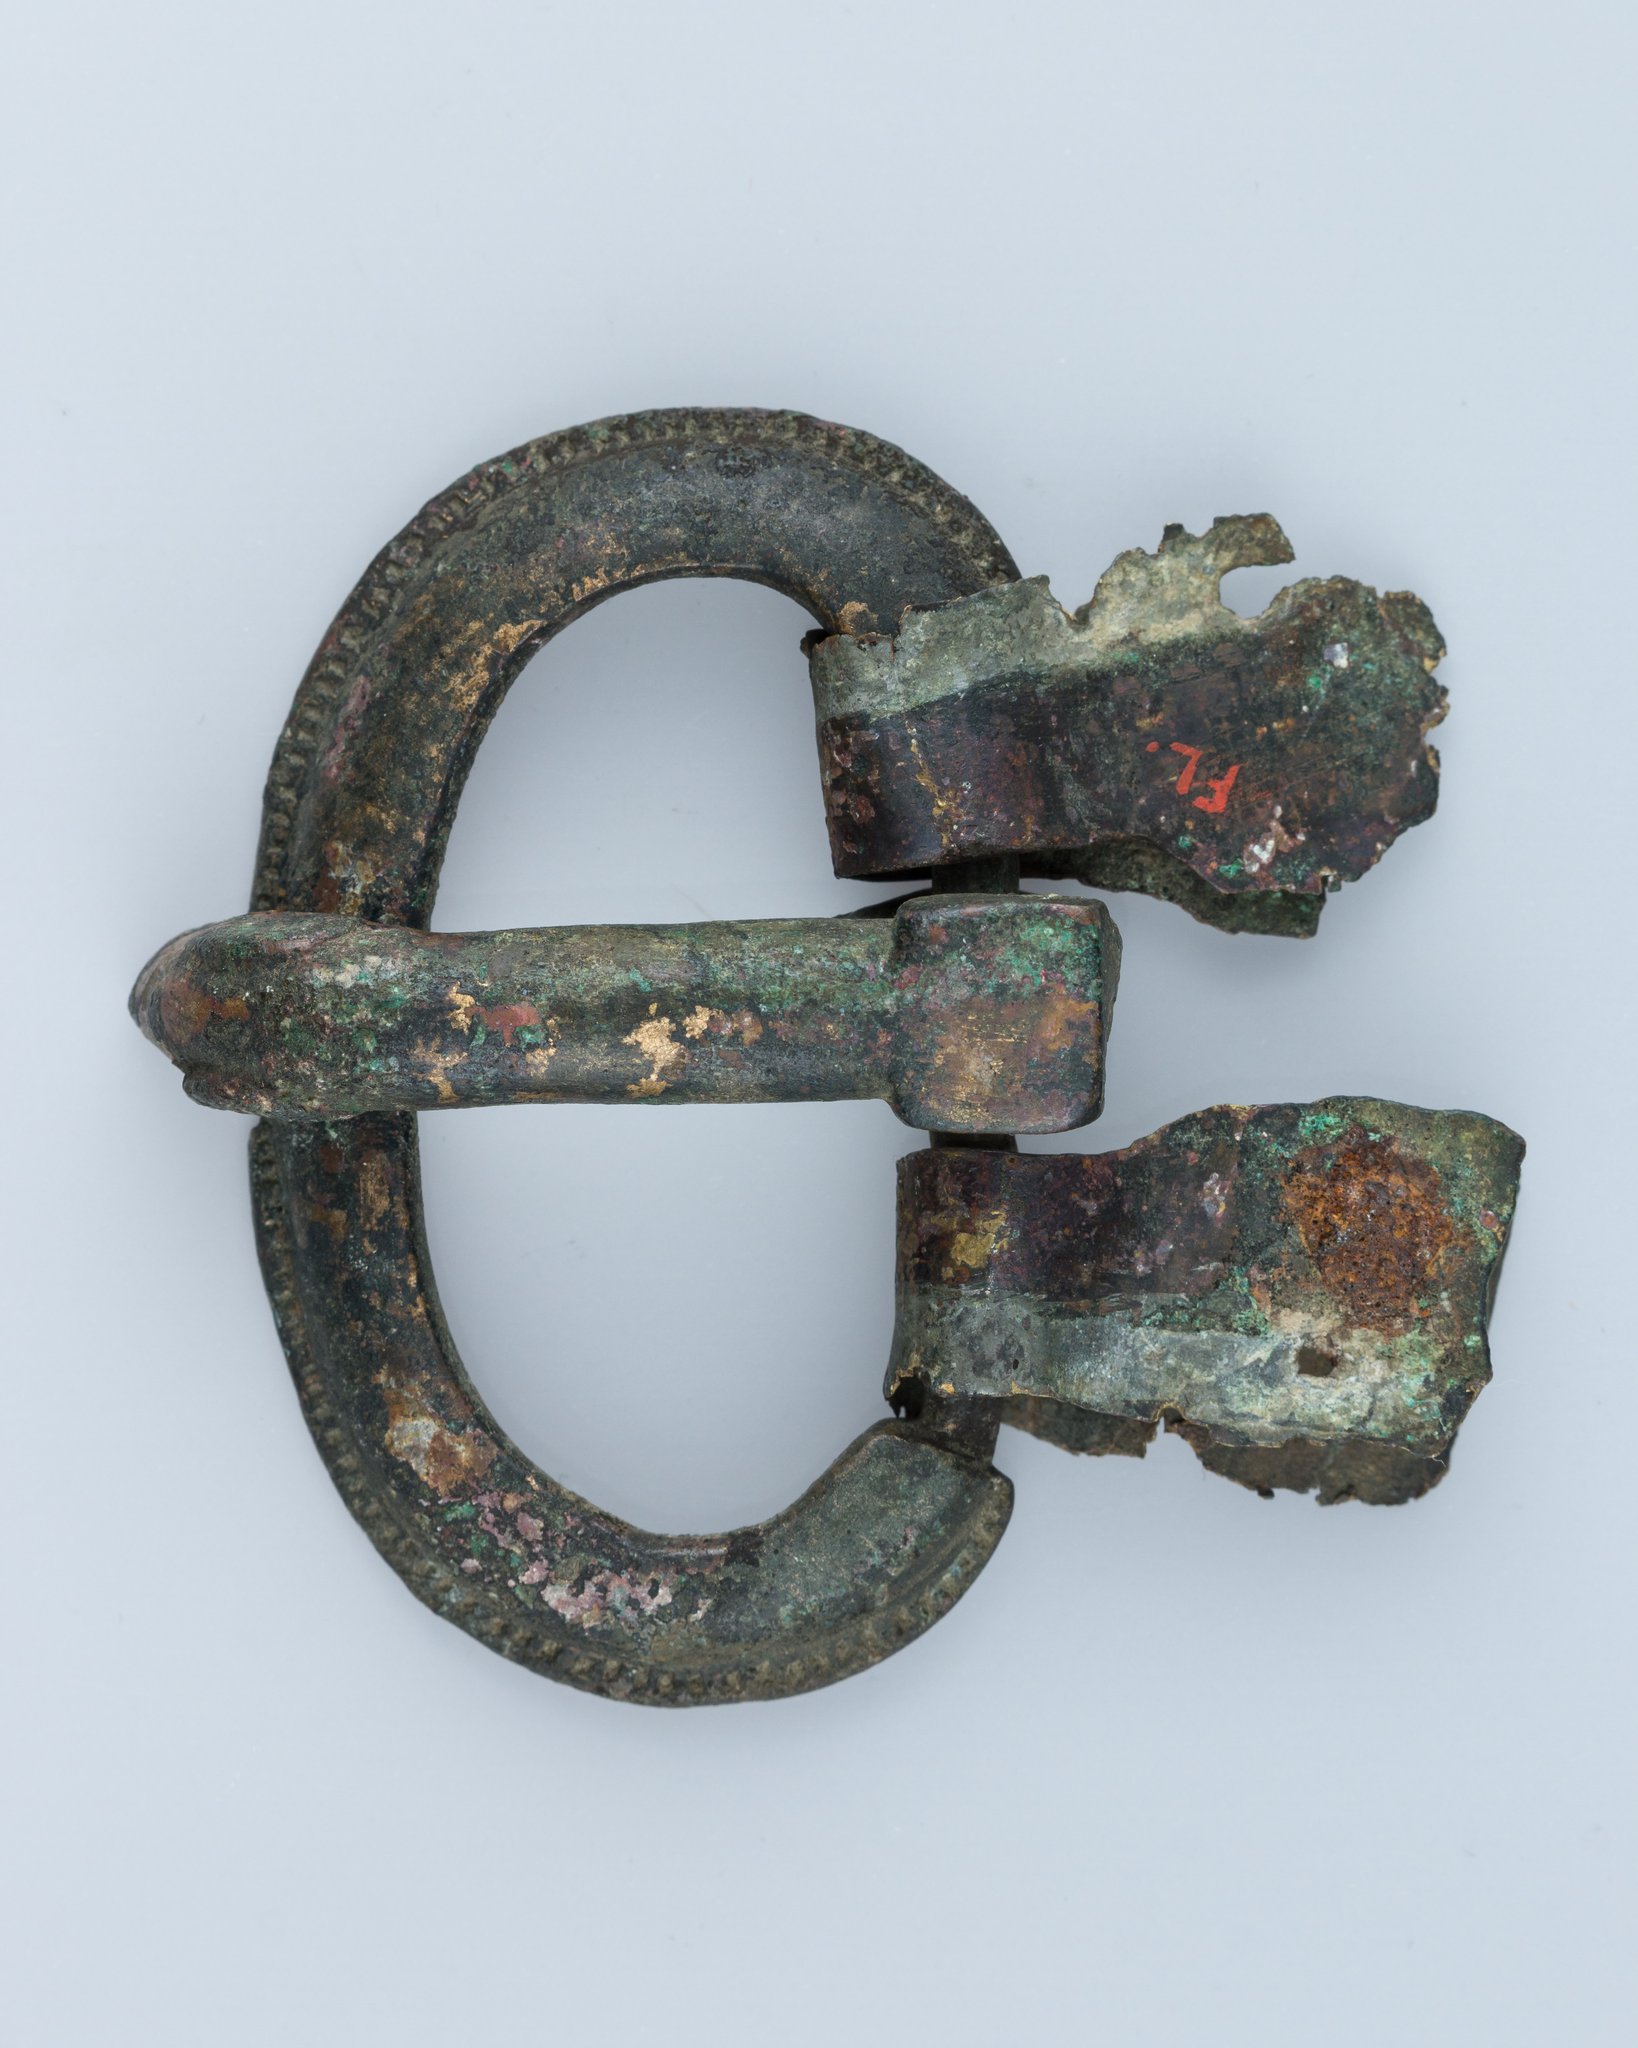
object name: buckle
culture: visigothic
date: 409-711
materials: bronze